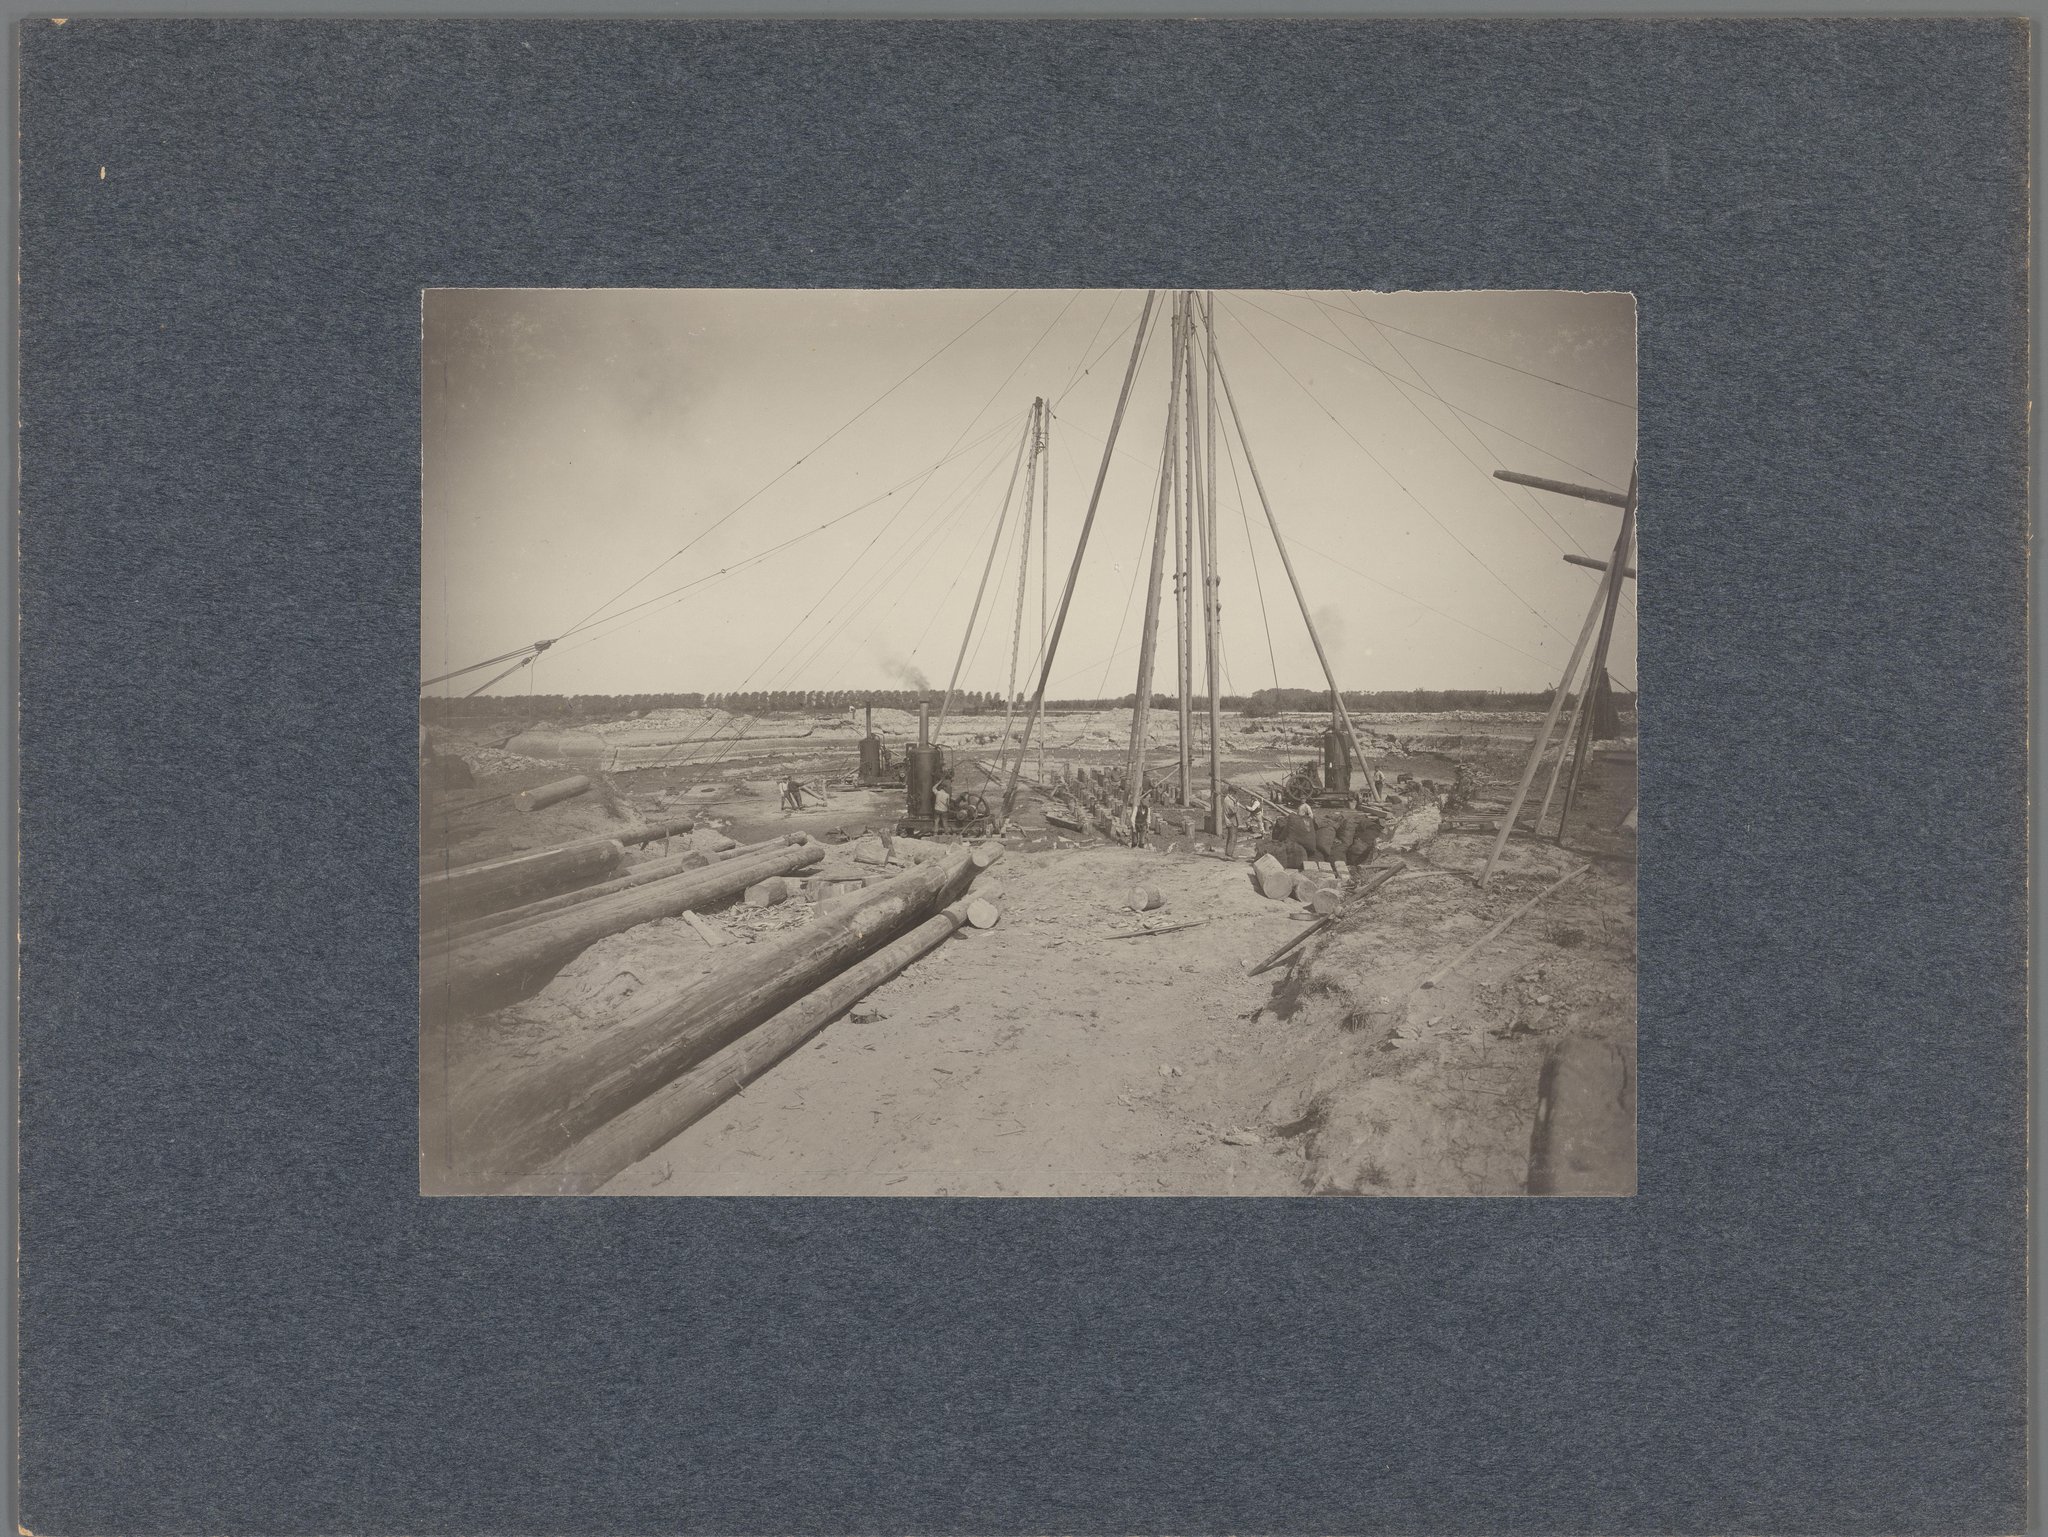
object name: photograph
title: Stoomheistellingen in de polder van Nieuw-Mathenesse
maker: willem sr. bleuzé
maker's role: fotograaf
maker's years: 1873-1948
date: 1912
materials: paper, cardboard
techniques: gelatin silver print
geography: rotterdam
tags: laying the foundations; trench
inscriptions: address: ‘W. BLEUZÉ/ ROTTERDAM/ JONKER FRANSSTRAAT 66’